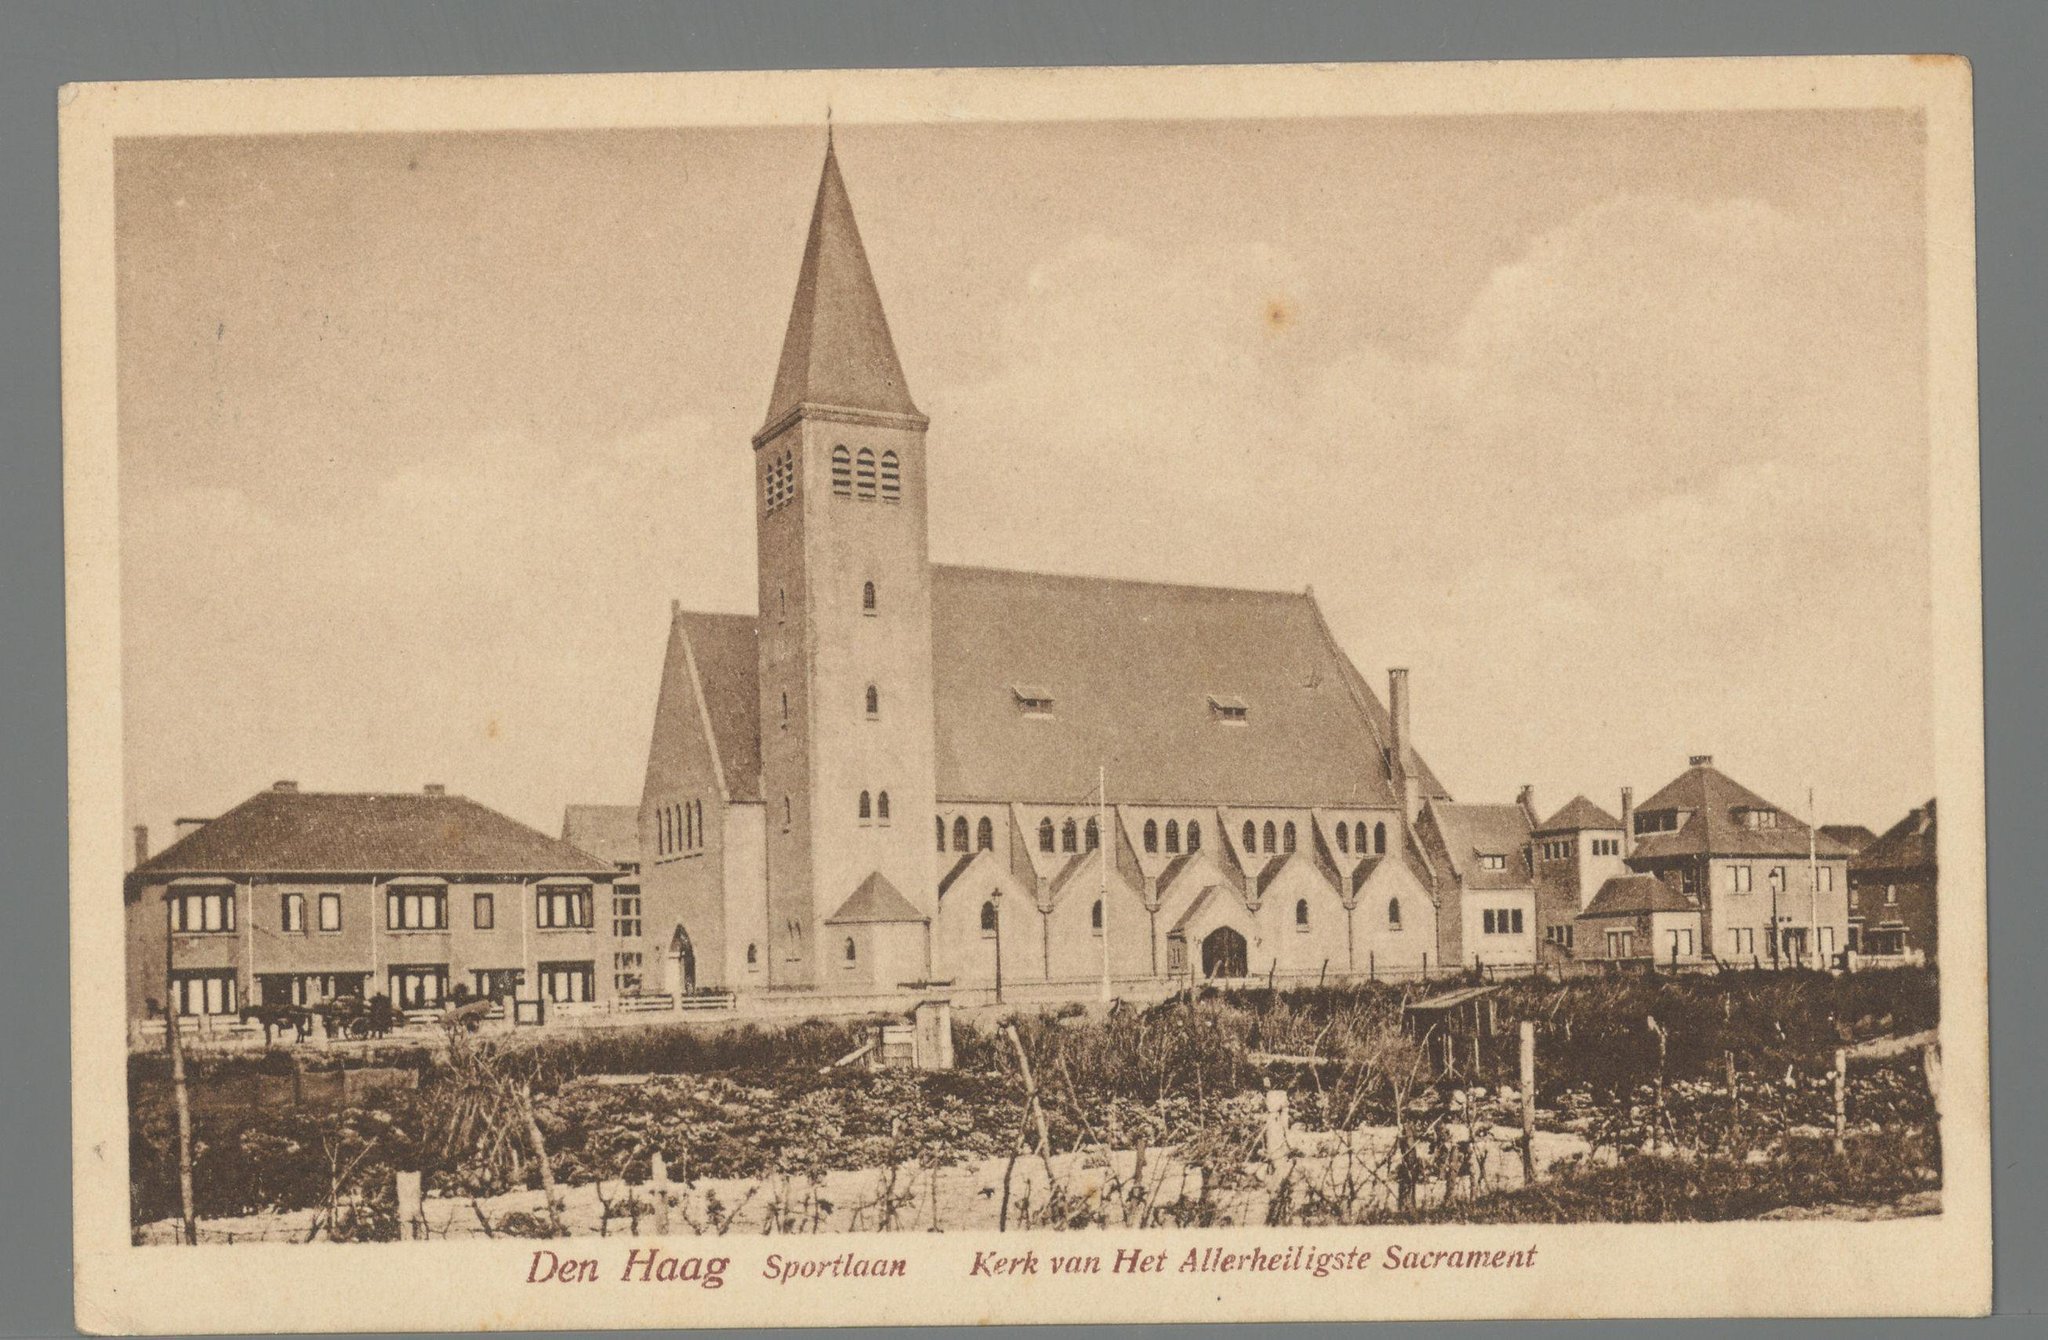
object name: photomechanical print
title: Den Haag. Sportlaan. Kerk van Het Allerheiligste Sacrament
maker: Anonymous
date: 1913-1928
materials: cardboard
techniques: photograph, writing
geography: the hague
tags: city-view, and landscape with man-made constructions, church (exterior)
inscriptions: poststempel, verso, gestempeld